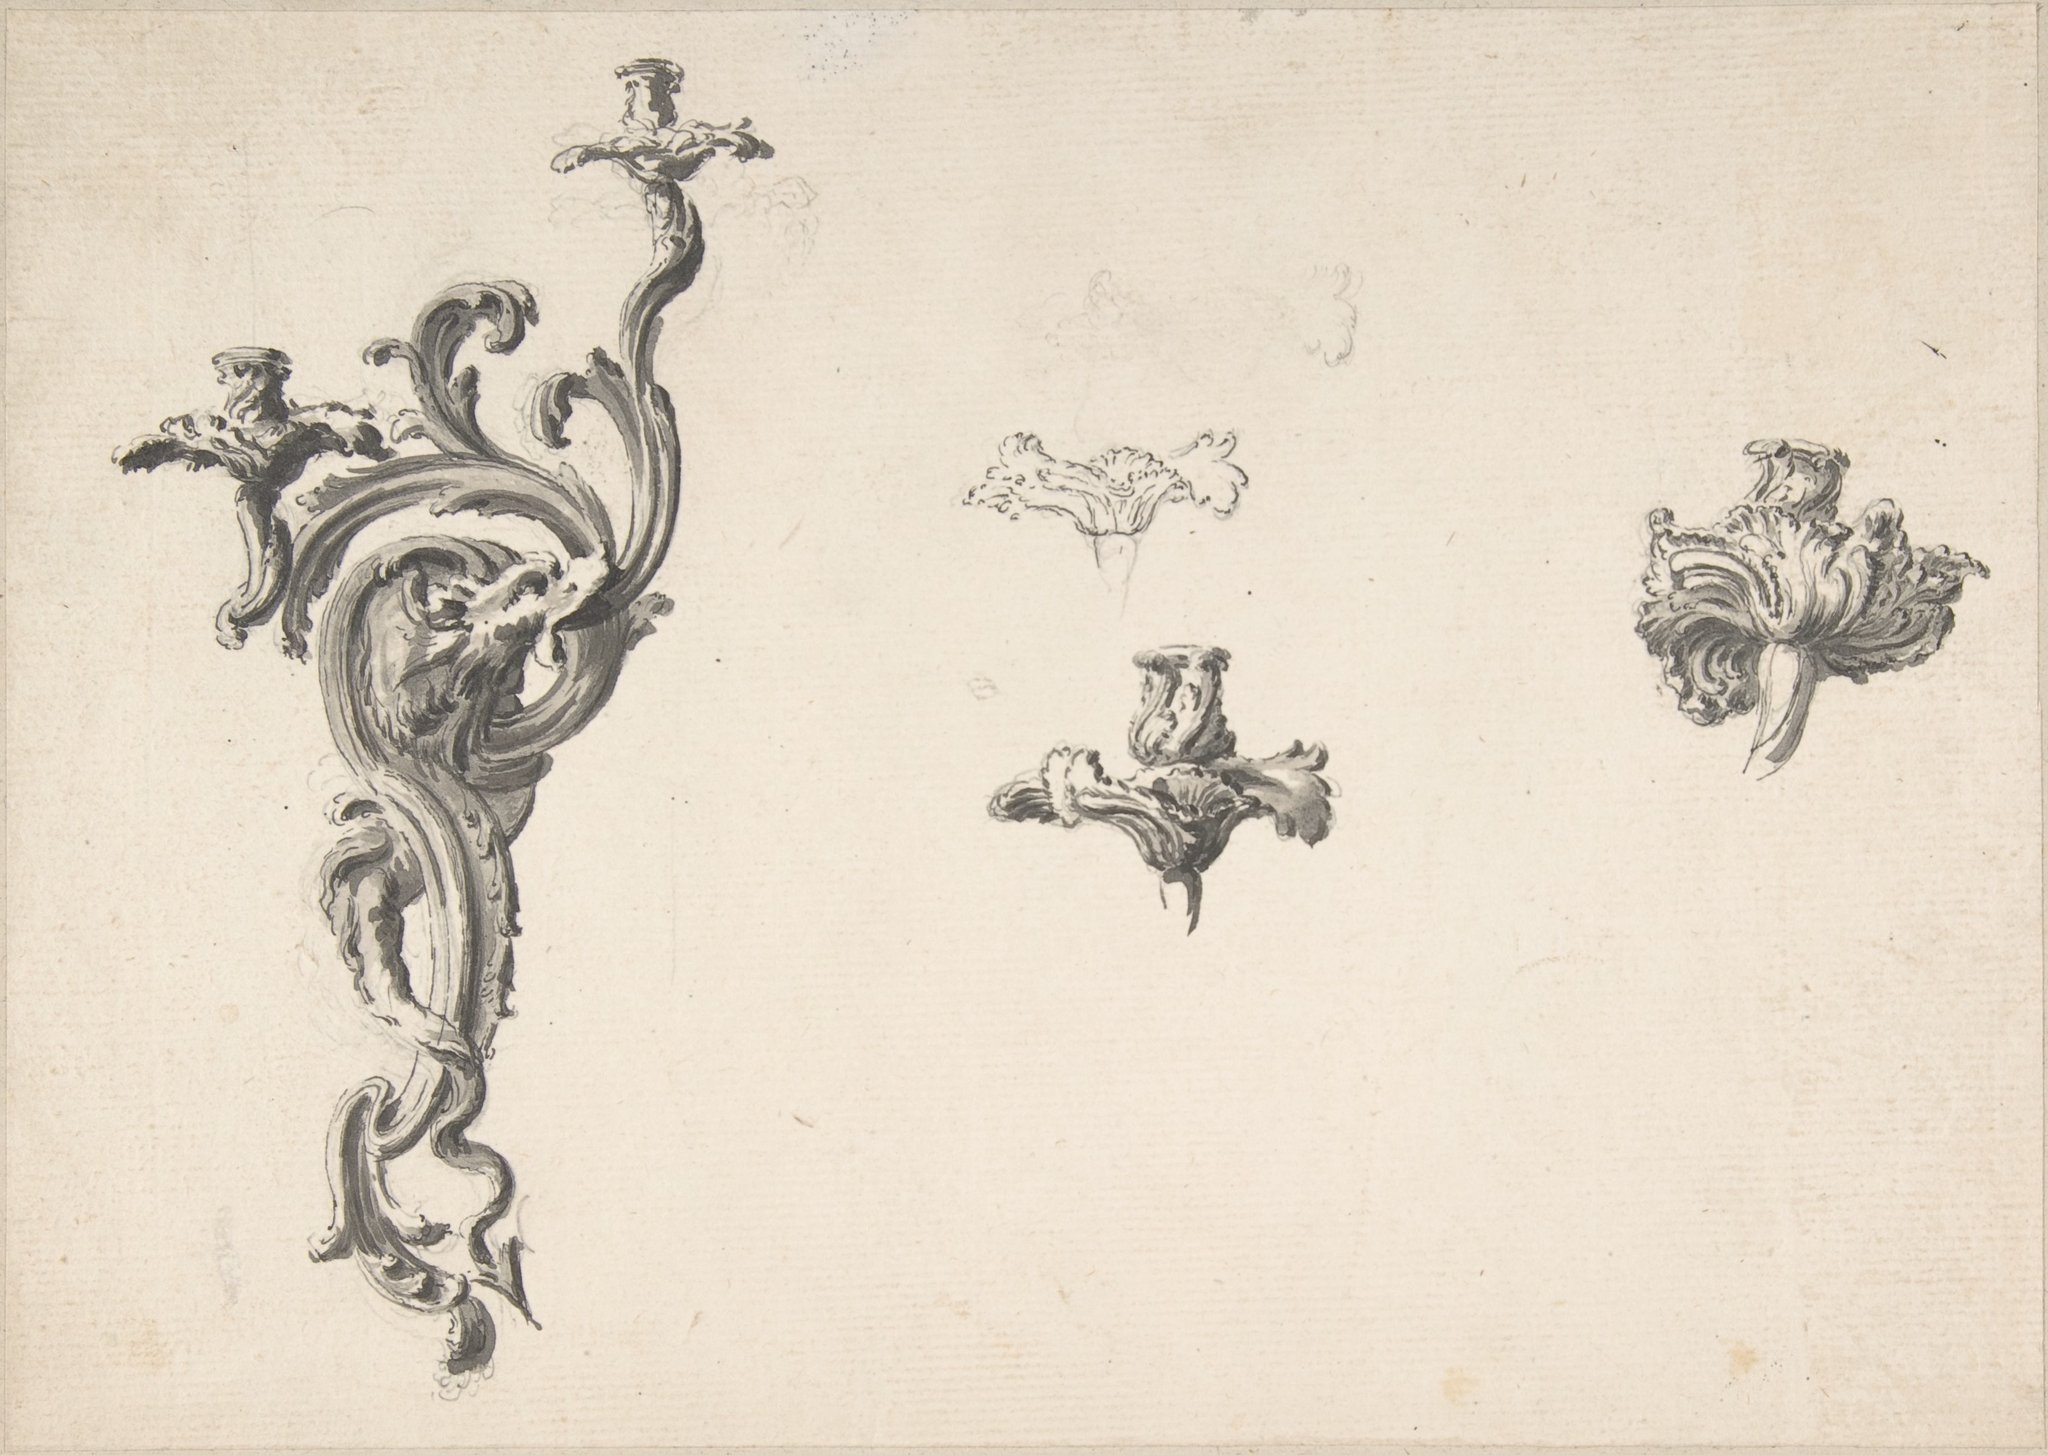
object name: drawing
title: Design for a Sconce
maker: anonymous, french, 18th century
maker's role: artist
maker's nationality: french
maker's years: 1700-1800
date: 1701-1800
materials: ink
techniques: brush, pen, wash